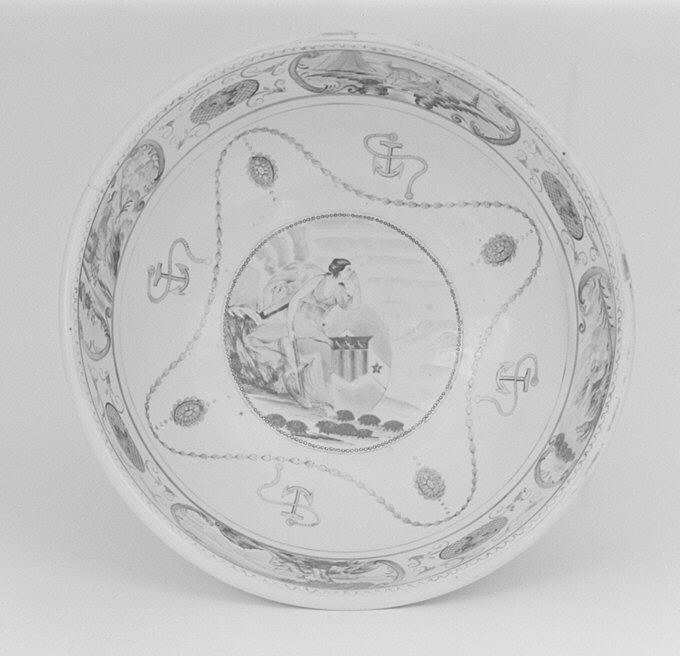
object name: basin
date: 1795-1800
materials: hard paste porcelain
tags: women,coat of arms